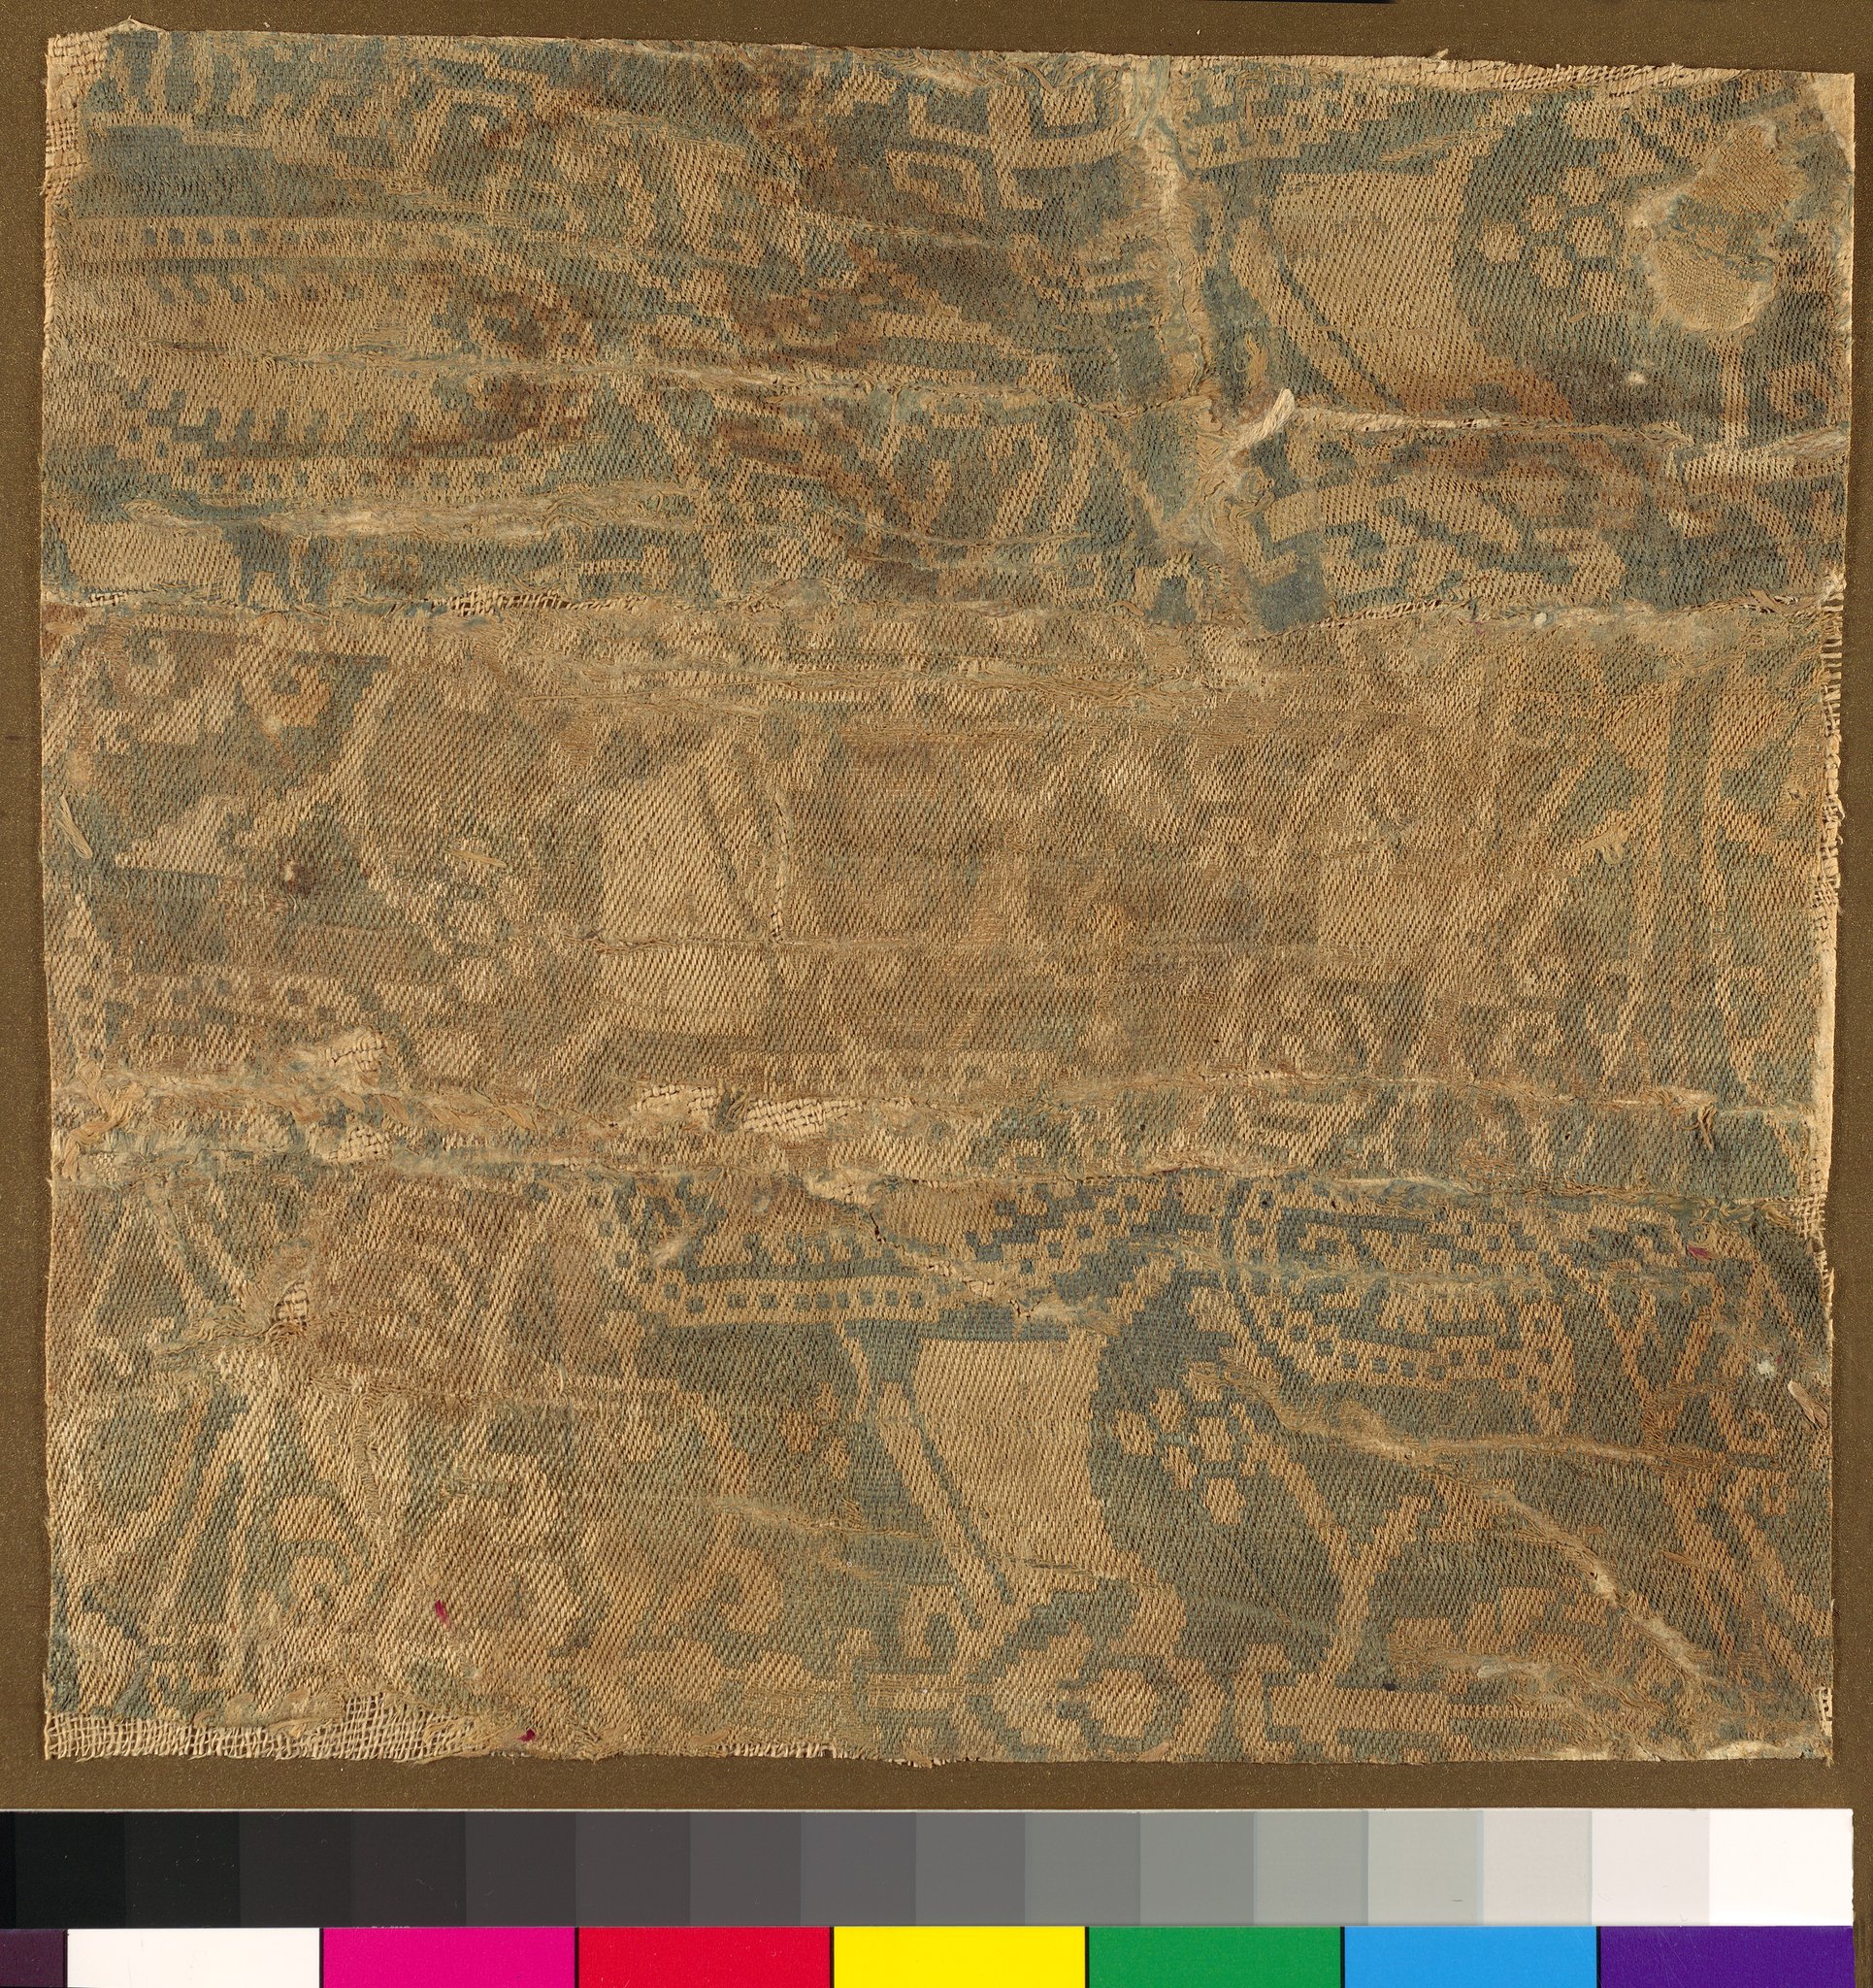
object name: textile fragment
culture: byzantine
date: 701-800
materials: silk